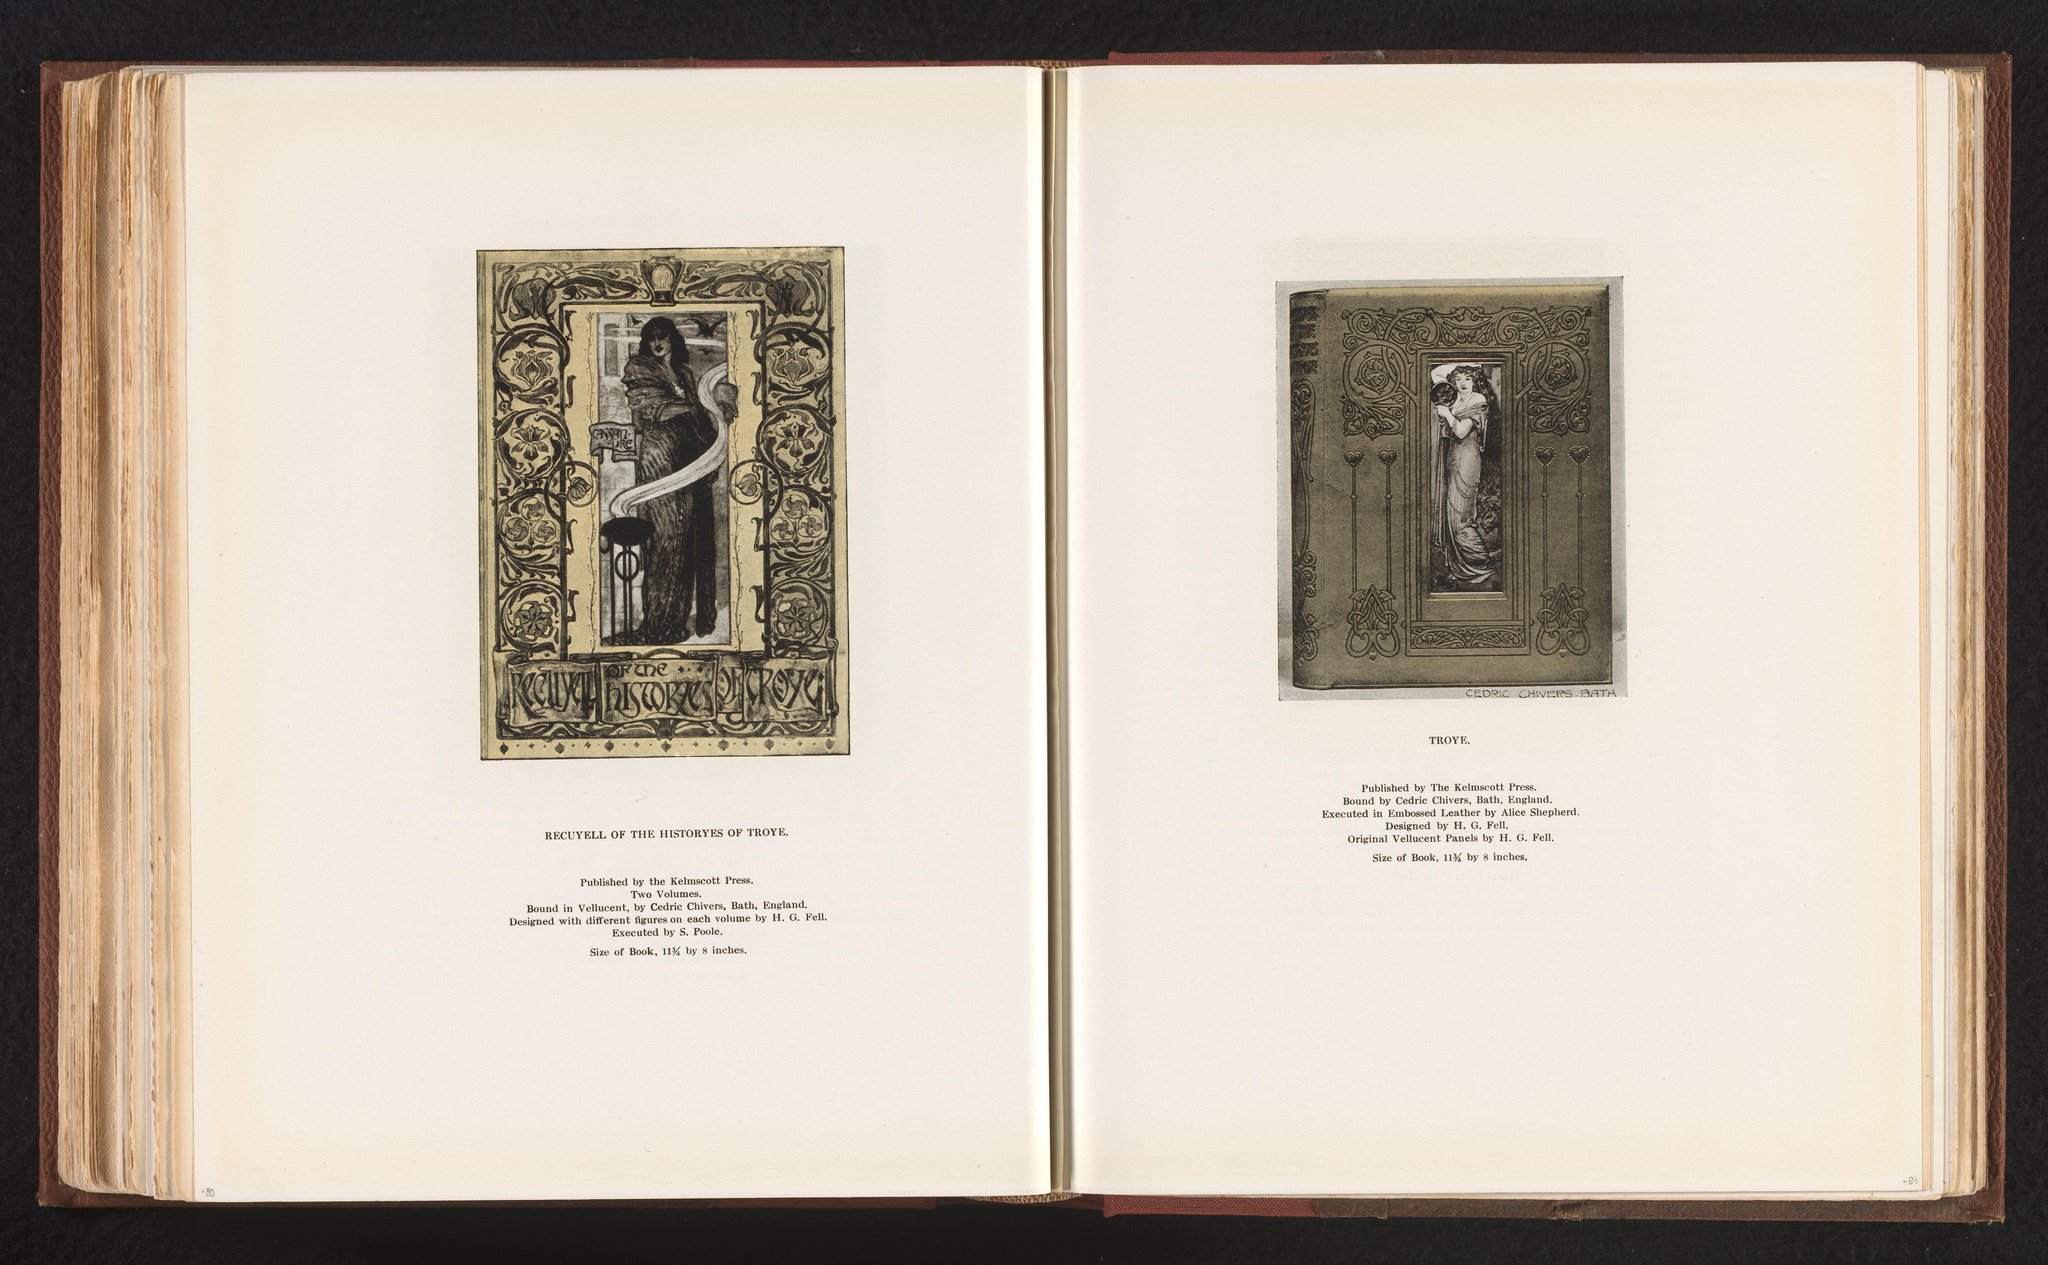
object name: page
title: Recuyell of the Historyes of Troye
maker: Anonymous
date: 1904-1909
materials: paper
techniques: color autotype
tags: book-cover, binding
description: Prent op tweede ongenummerde pagina na pagina 324.